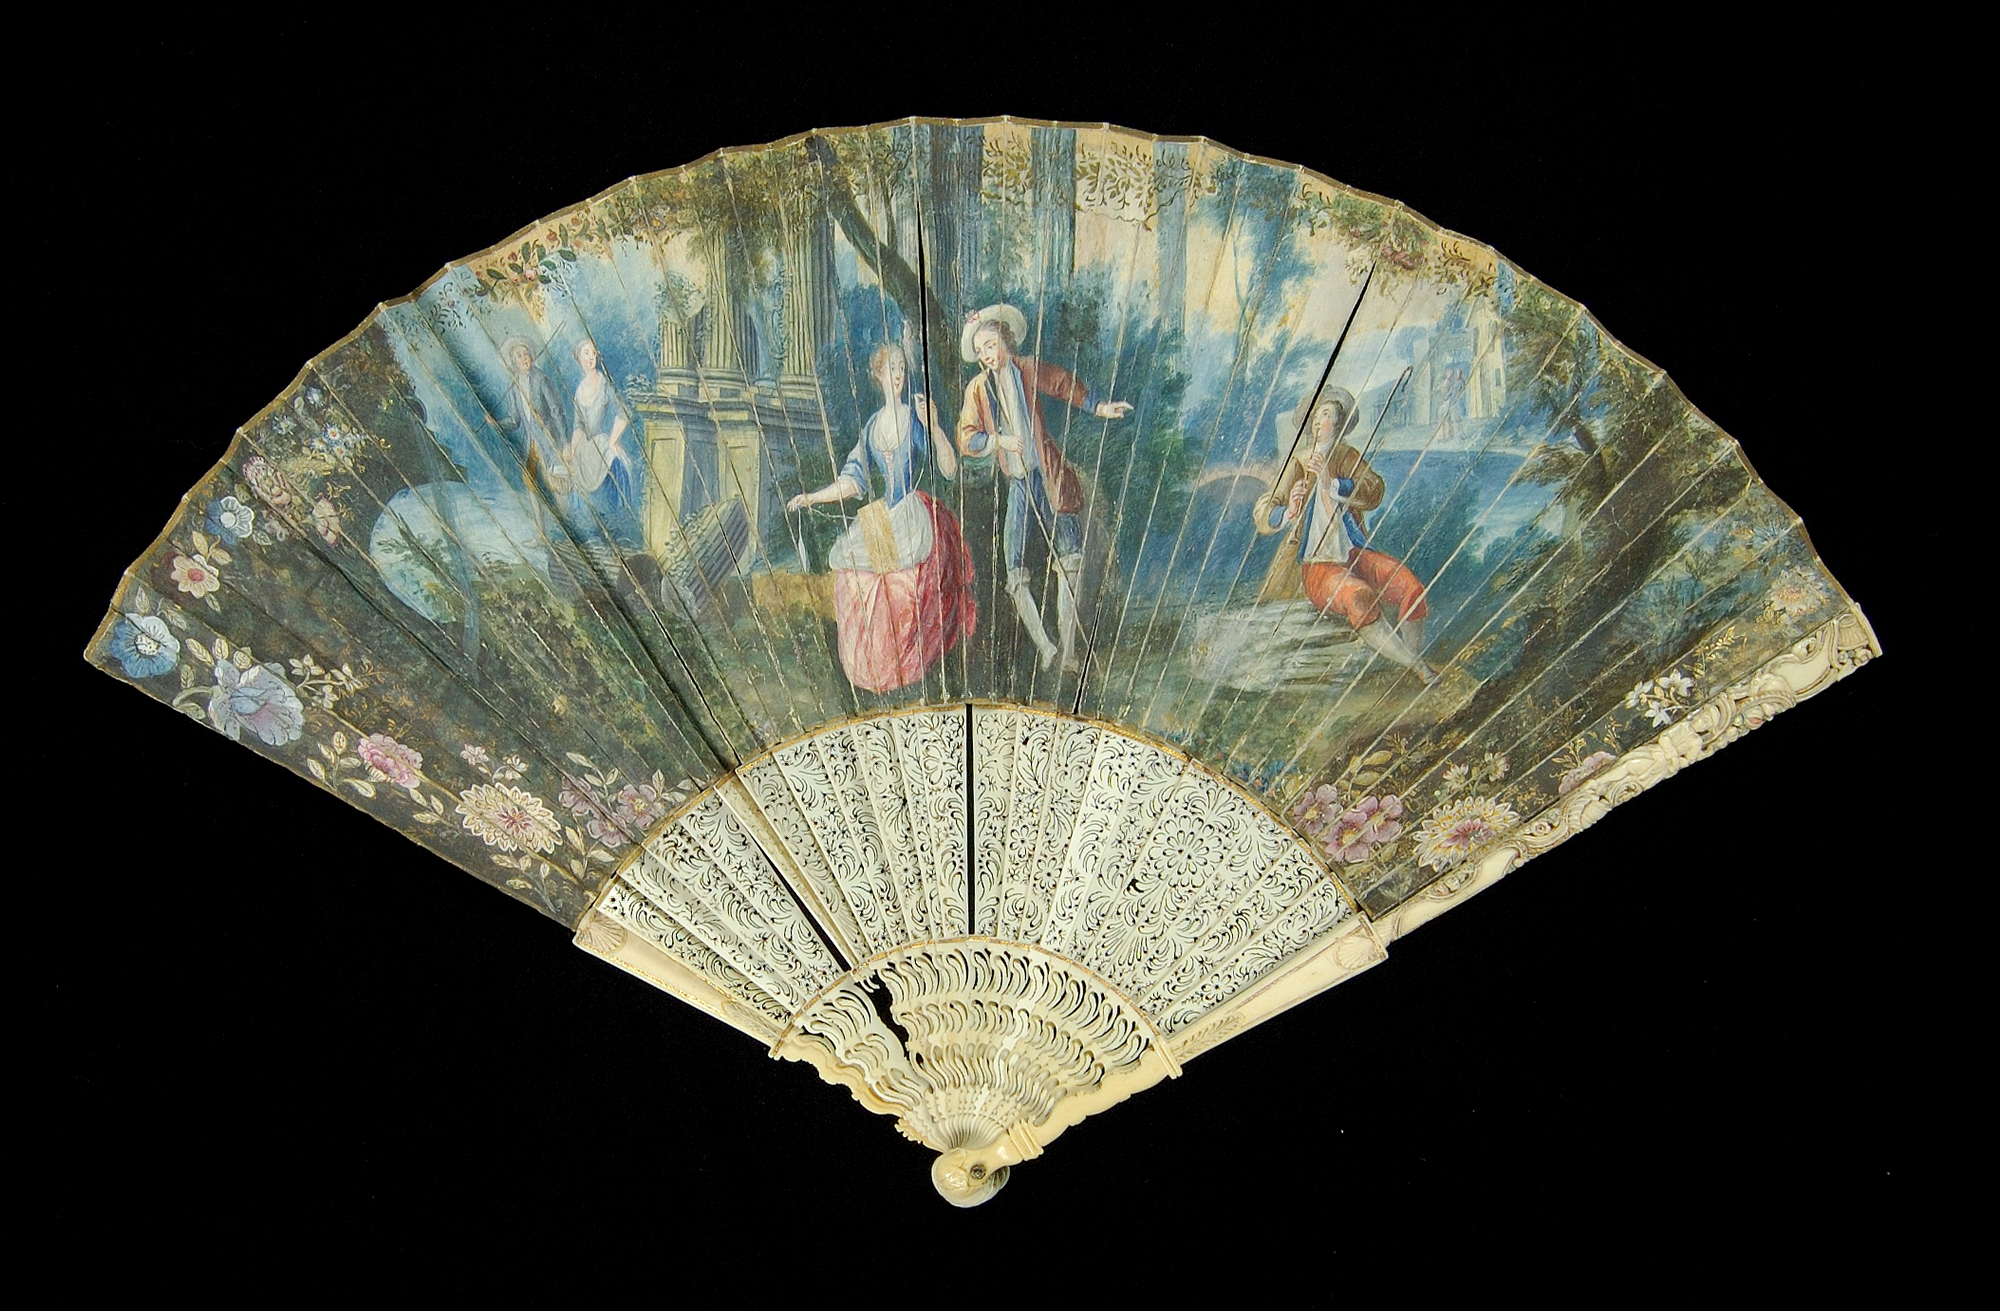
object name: fan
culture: european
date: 1776-1800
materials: ivory, paper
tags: musical instruments,men,women,flowers